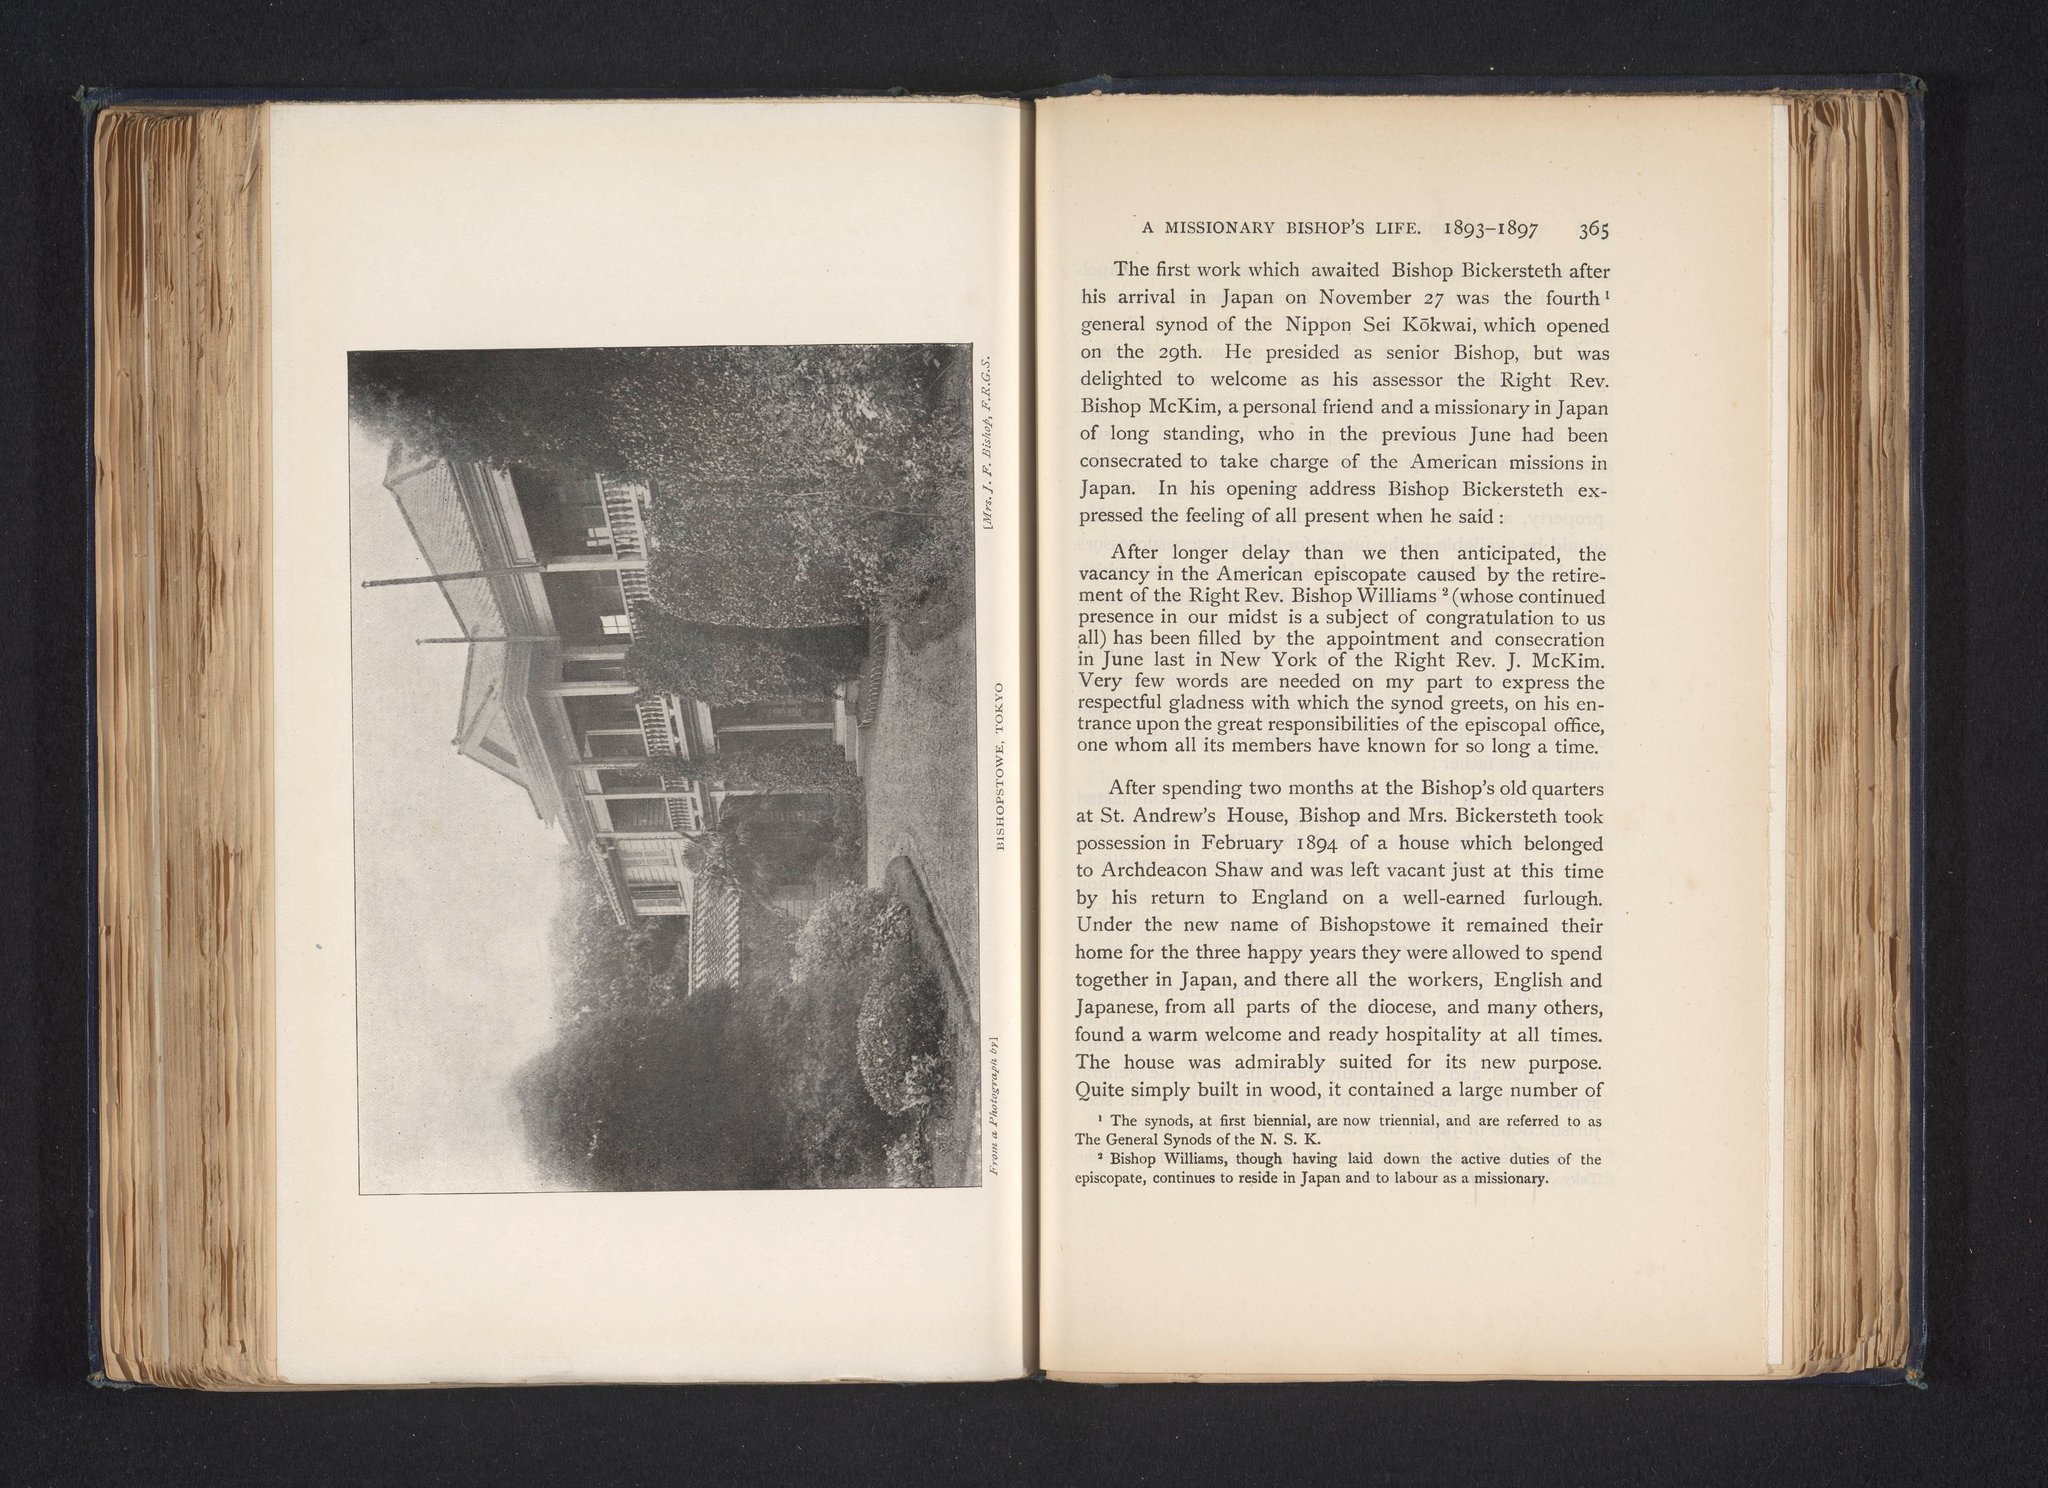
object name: page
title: Bishopstowe, Tokyo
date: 1893-1899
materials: paper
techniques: autotype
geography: tokyo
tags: rural housing, e.g. country-house, villa, cottage, façade (of house or building)